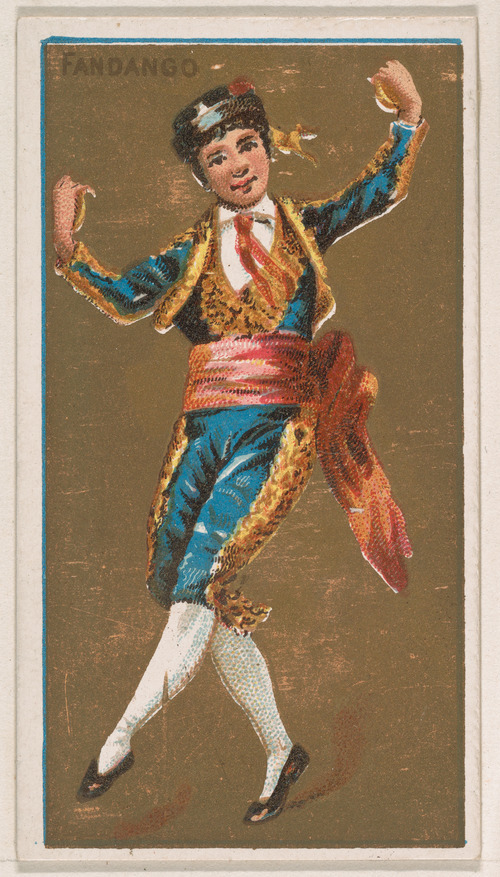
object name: print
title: Fandango, from National Dances (N225, Type 1) issued by Kinney Bros.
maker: kinney brothers tobacco company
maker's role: publisher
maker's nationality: american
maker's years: 1869-2011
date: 1889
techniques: color lithograph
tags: women,dancing,dancers